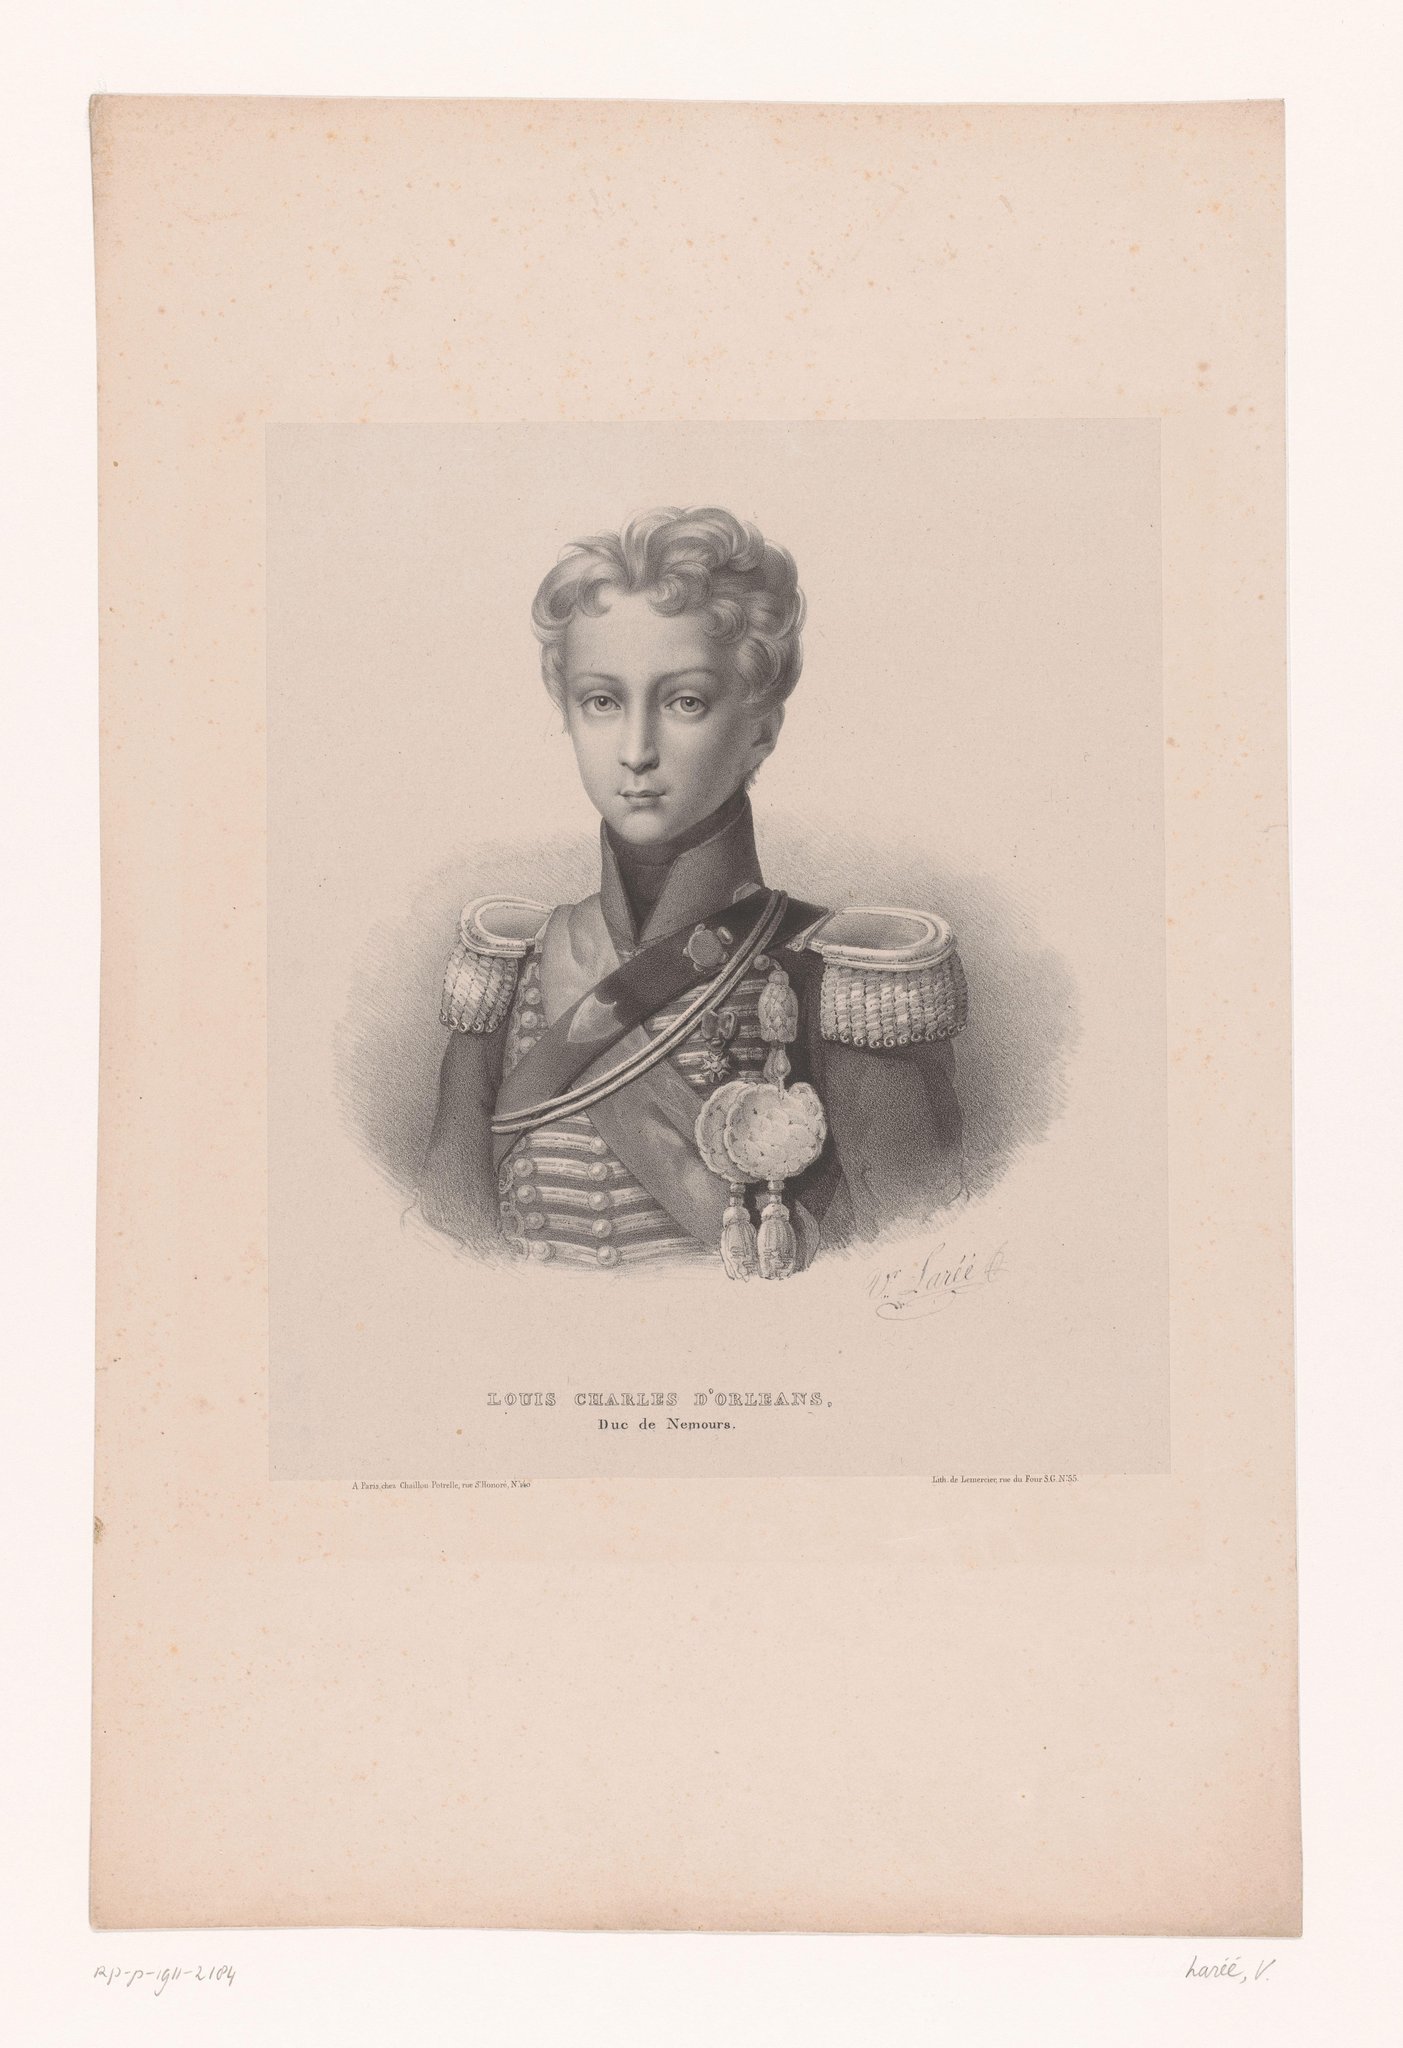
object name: print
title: Portret van Lodewijk Karel van Orléans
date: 1831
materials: paper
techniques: lithograph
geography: paris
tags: paris, historical persons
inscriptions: collector's mark: Lugt 2228a